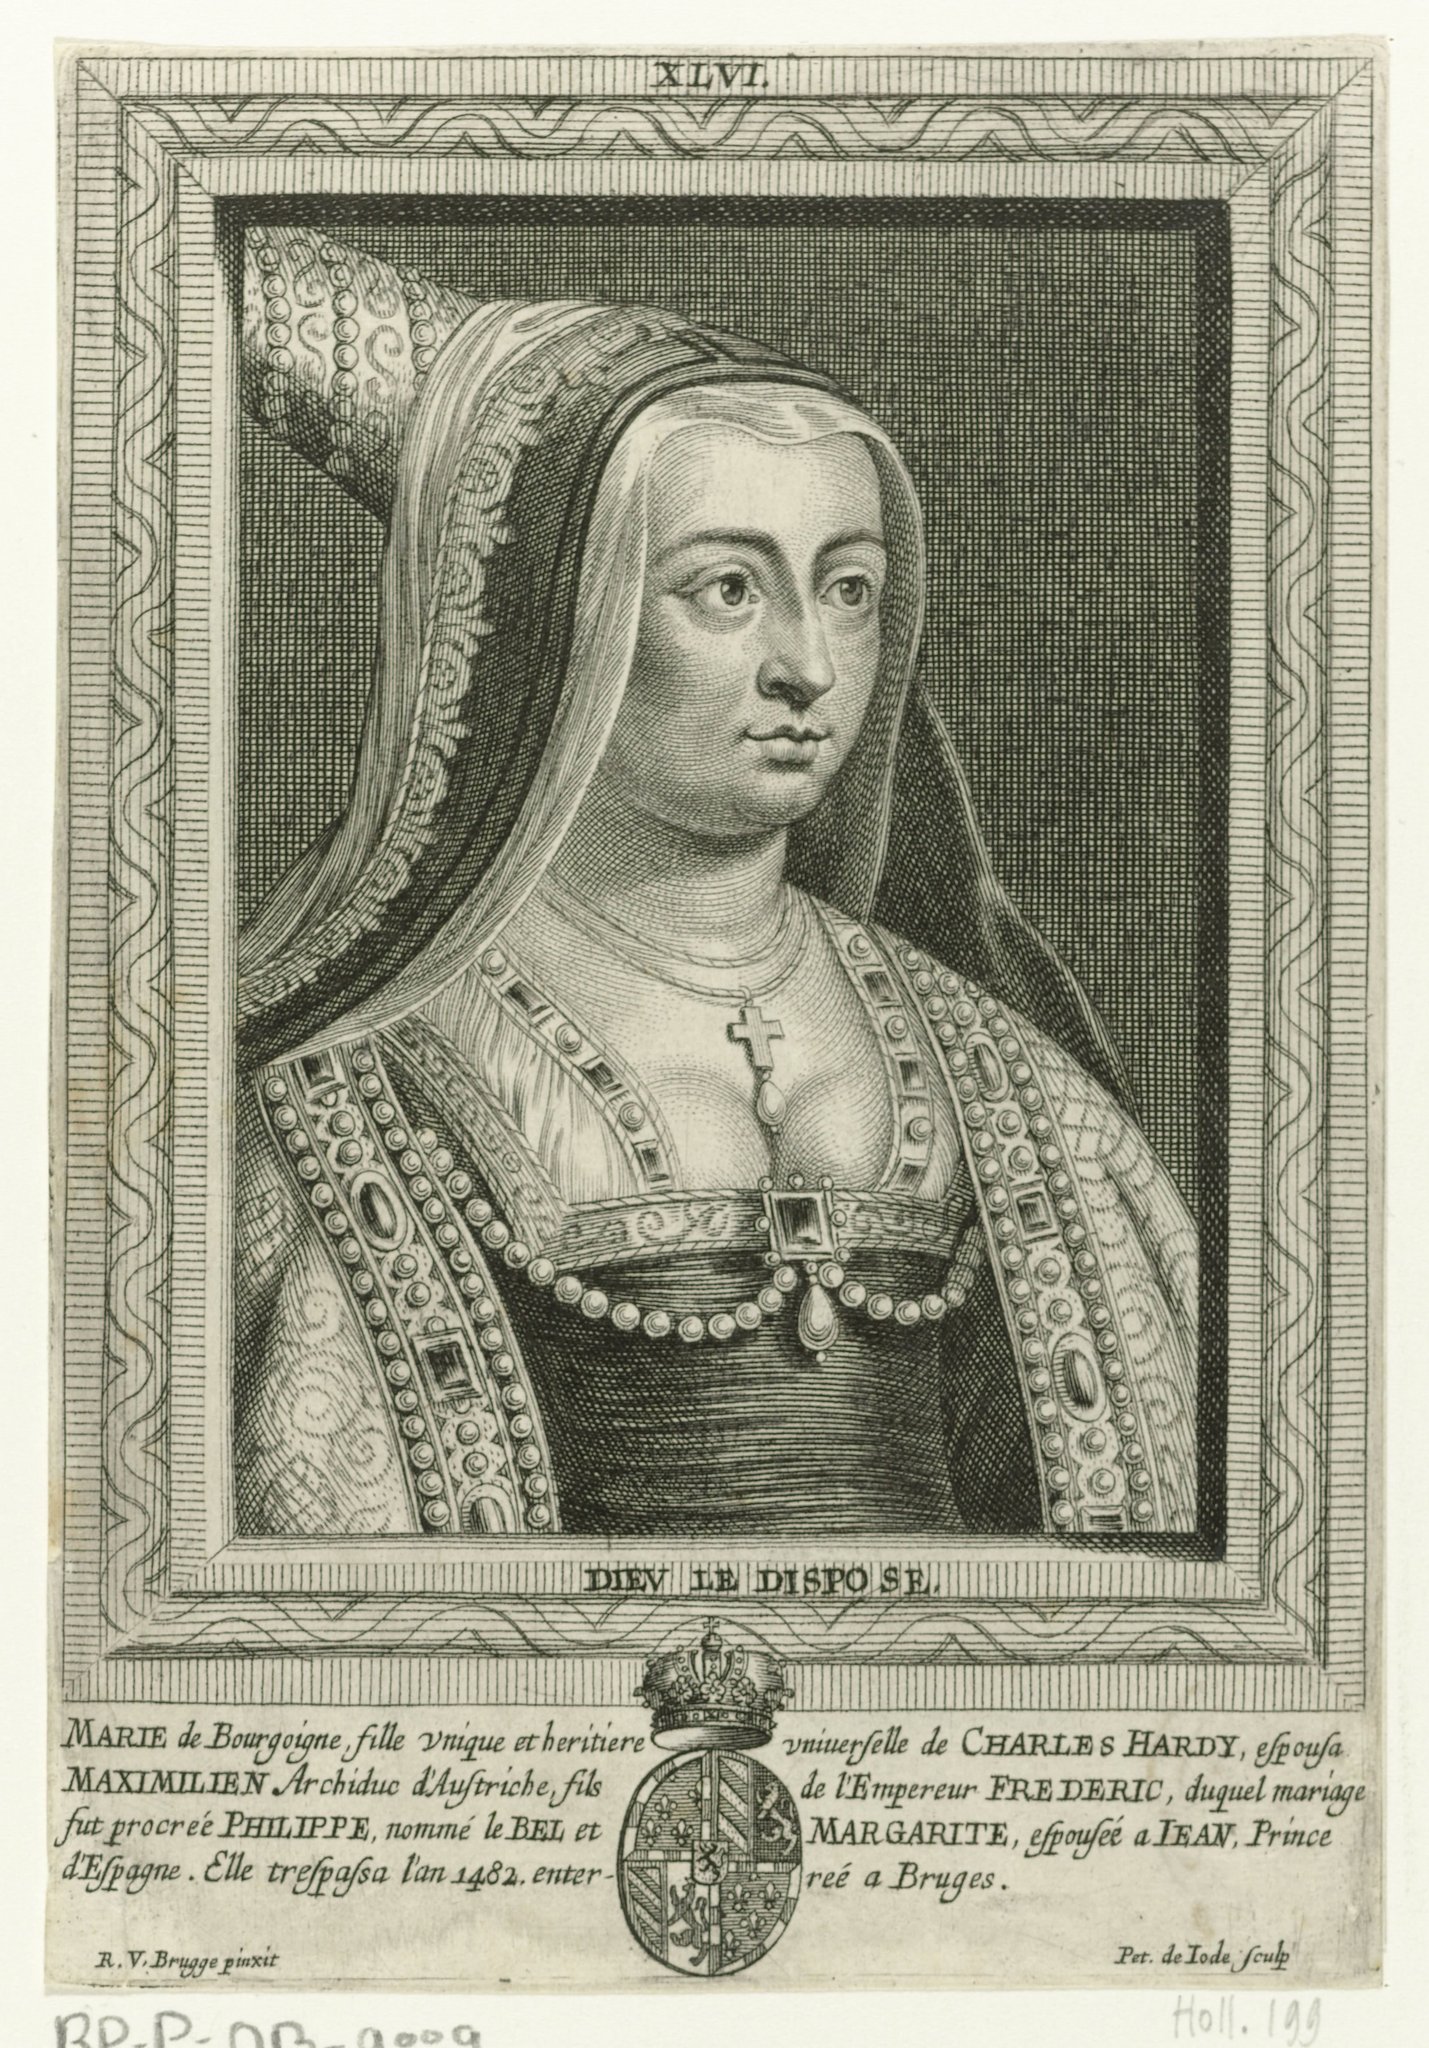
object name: print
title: Portret van Maria, hertogin van Bourgondië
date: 1661-1663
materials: paper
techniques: engraving, etching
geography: antwerp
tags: brussels, bruges, maria (hertogin van bourgondië), veil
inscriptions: collector's mark: Lugt 240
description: Busteportret van Maria van Bourgondië, met puntig hoofddeksel met sluier. Ze draagt een ketting en een rijk versierde jurk met laag uitgesneden decolleté. Het portret is gevat in een rechthoekige omlijsting met een motto in het Latijn. In de marge het wapenschild van de geportretteerde en een vierregelig onderschrift in het Frans. Prent uit een boek waarin 54 prenten met portretten.